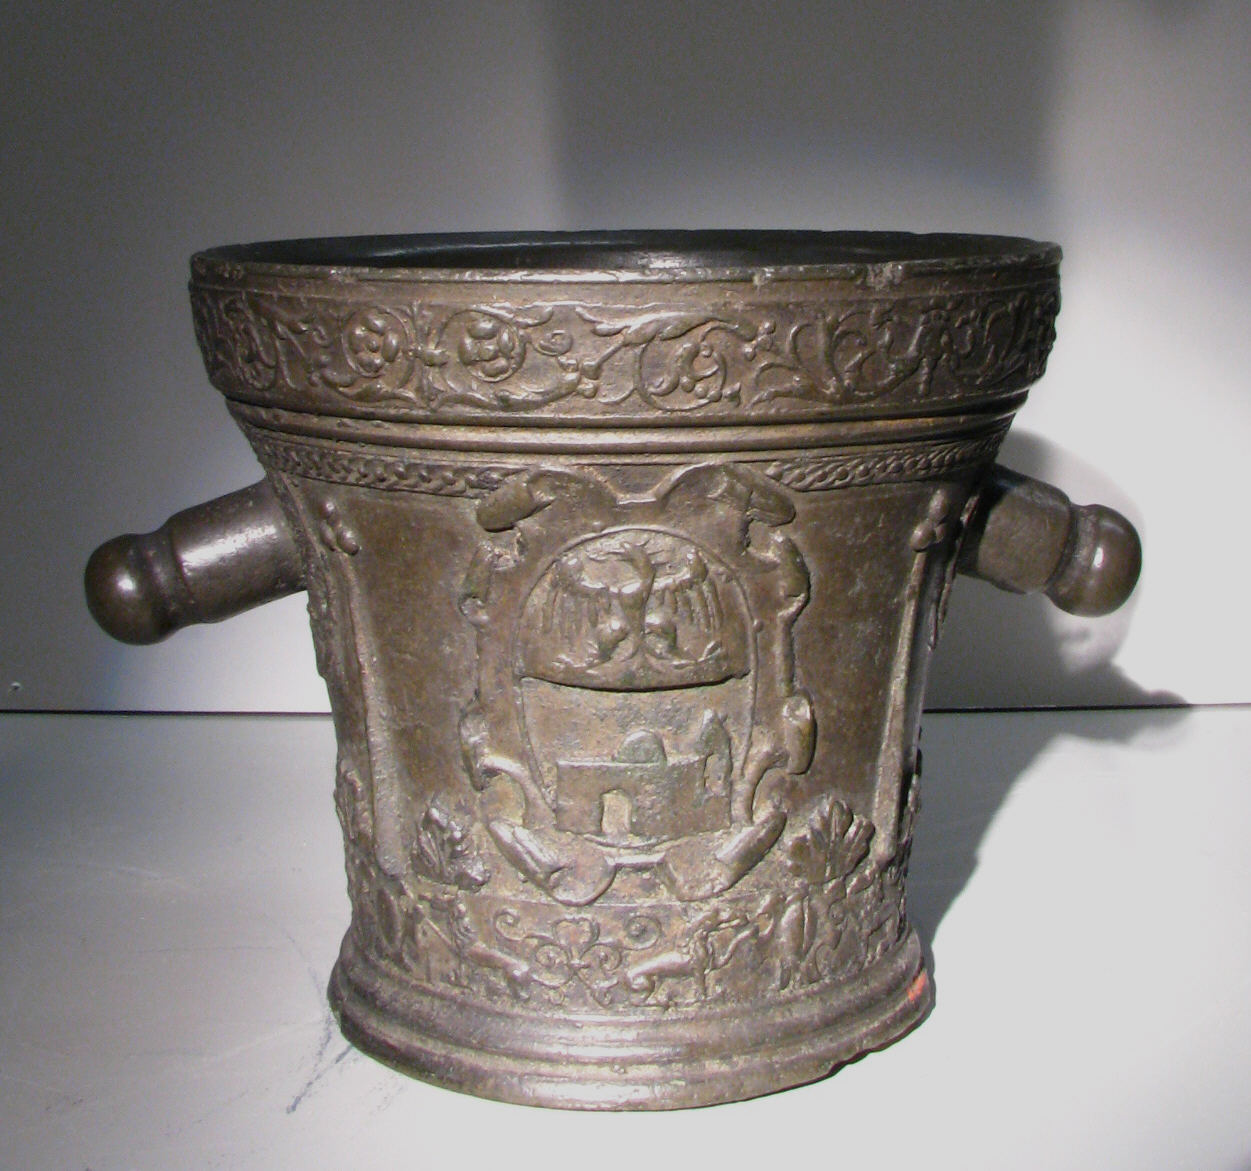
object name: mortar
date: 1501-1600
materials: bronze